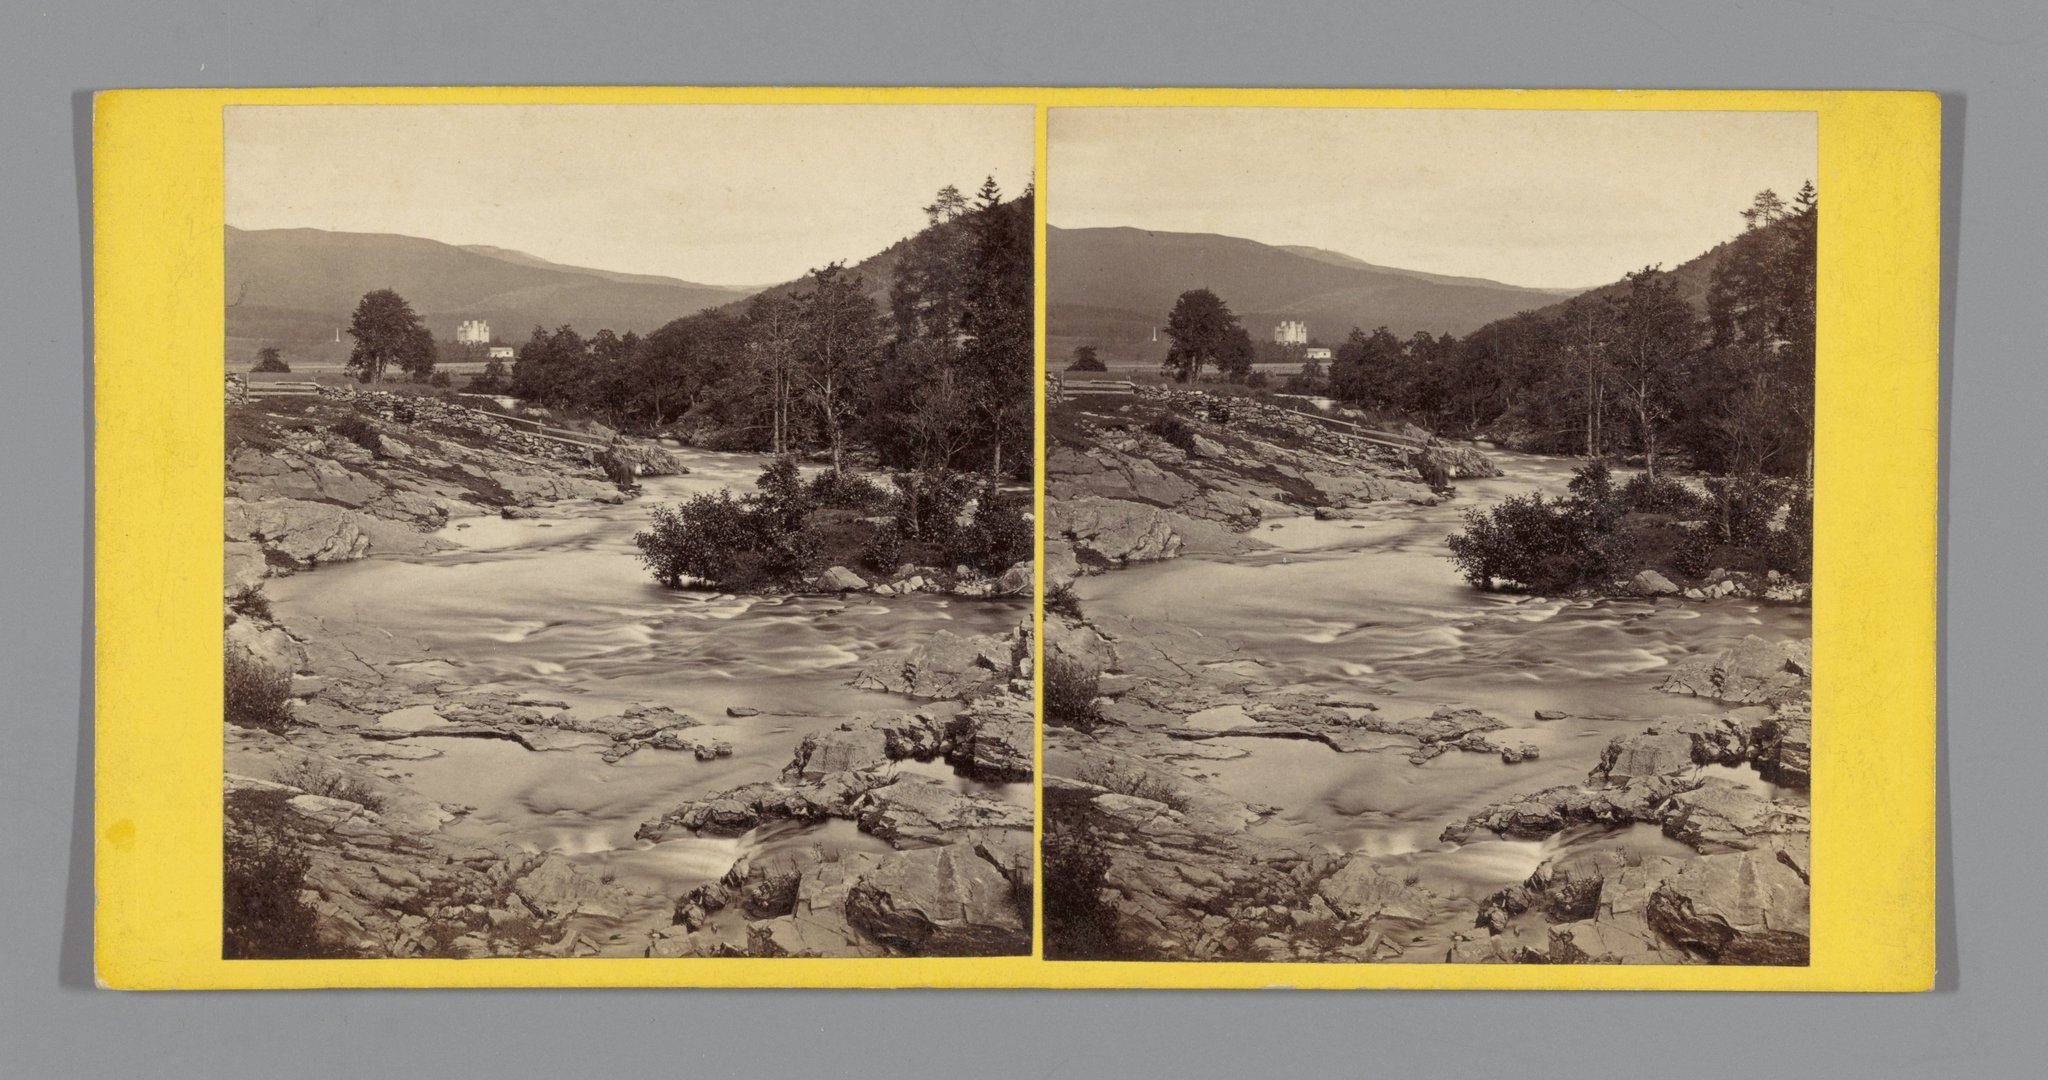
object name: stereograph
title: Braemar Castle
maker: george washington wilson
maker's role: publisher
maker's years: 1823-1893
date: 1850-1880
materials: cardboard, photographic support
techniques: albumen print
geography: aberdeenshire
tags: castle, river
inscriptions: name: ‘G. W. Wilson, Photographer, Aberdeen’, number: ‘No. 66.’